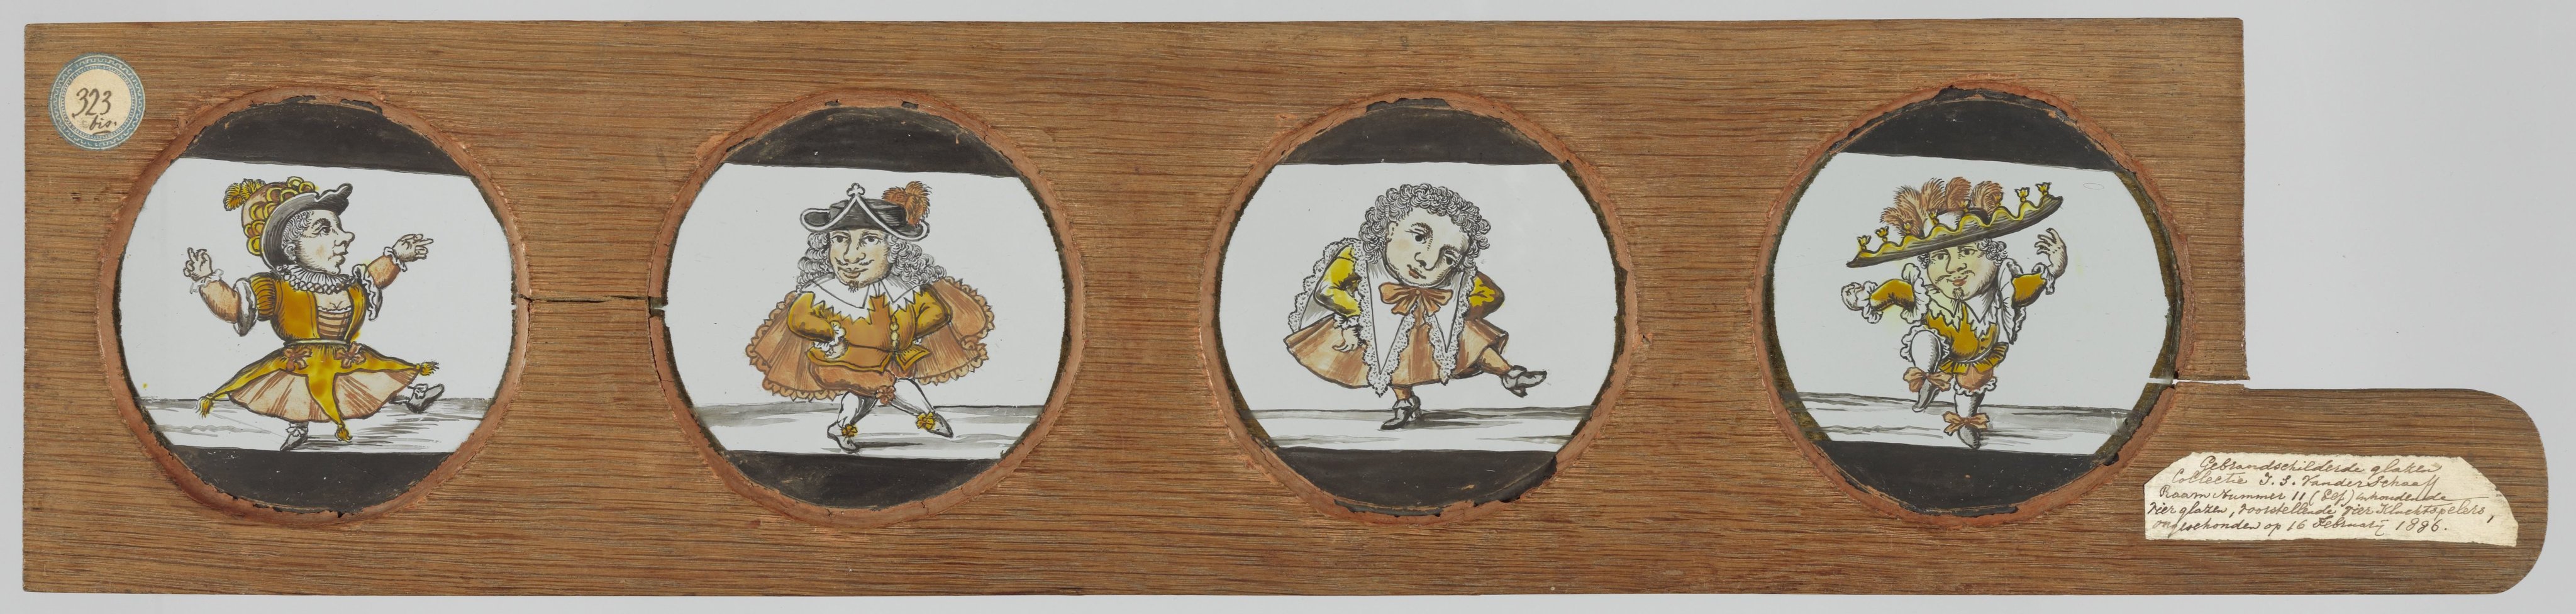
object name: lantern slide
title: Dansende kleine mensen (karikaturen)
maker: Anonymous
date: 1700-1790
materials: glass, wood, oil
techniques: painted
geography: netherlands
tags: one person dancing alone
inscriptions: label: ‘'Gebrandschilderde glazen. Collectie I.S. van der Schaaff, Baarn. Nummer 11 (elf) inhoudende vier glazen, voorstellende vier kluchtspelers. Alle glazen zijn geheel ongeschonden en heel op 18 februarij 1886.'’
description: Houten frame met vier ronde glasplaten met diverse voorstellingen gebruikt in toverlantaarn. links: een dansend vrouwtje. 2e van links: een dansende mannetje. 2e van rechts: een dansend mannetje. rechts: een dansend mannetje. Hij heeft een grote hoed op met veren. Deel van vierenzestig toverlantaarnplaten uit de collectie van I.S. van der Schaaff uit Baarn.